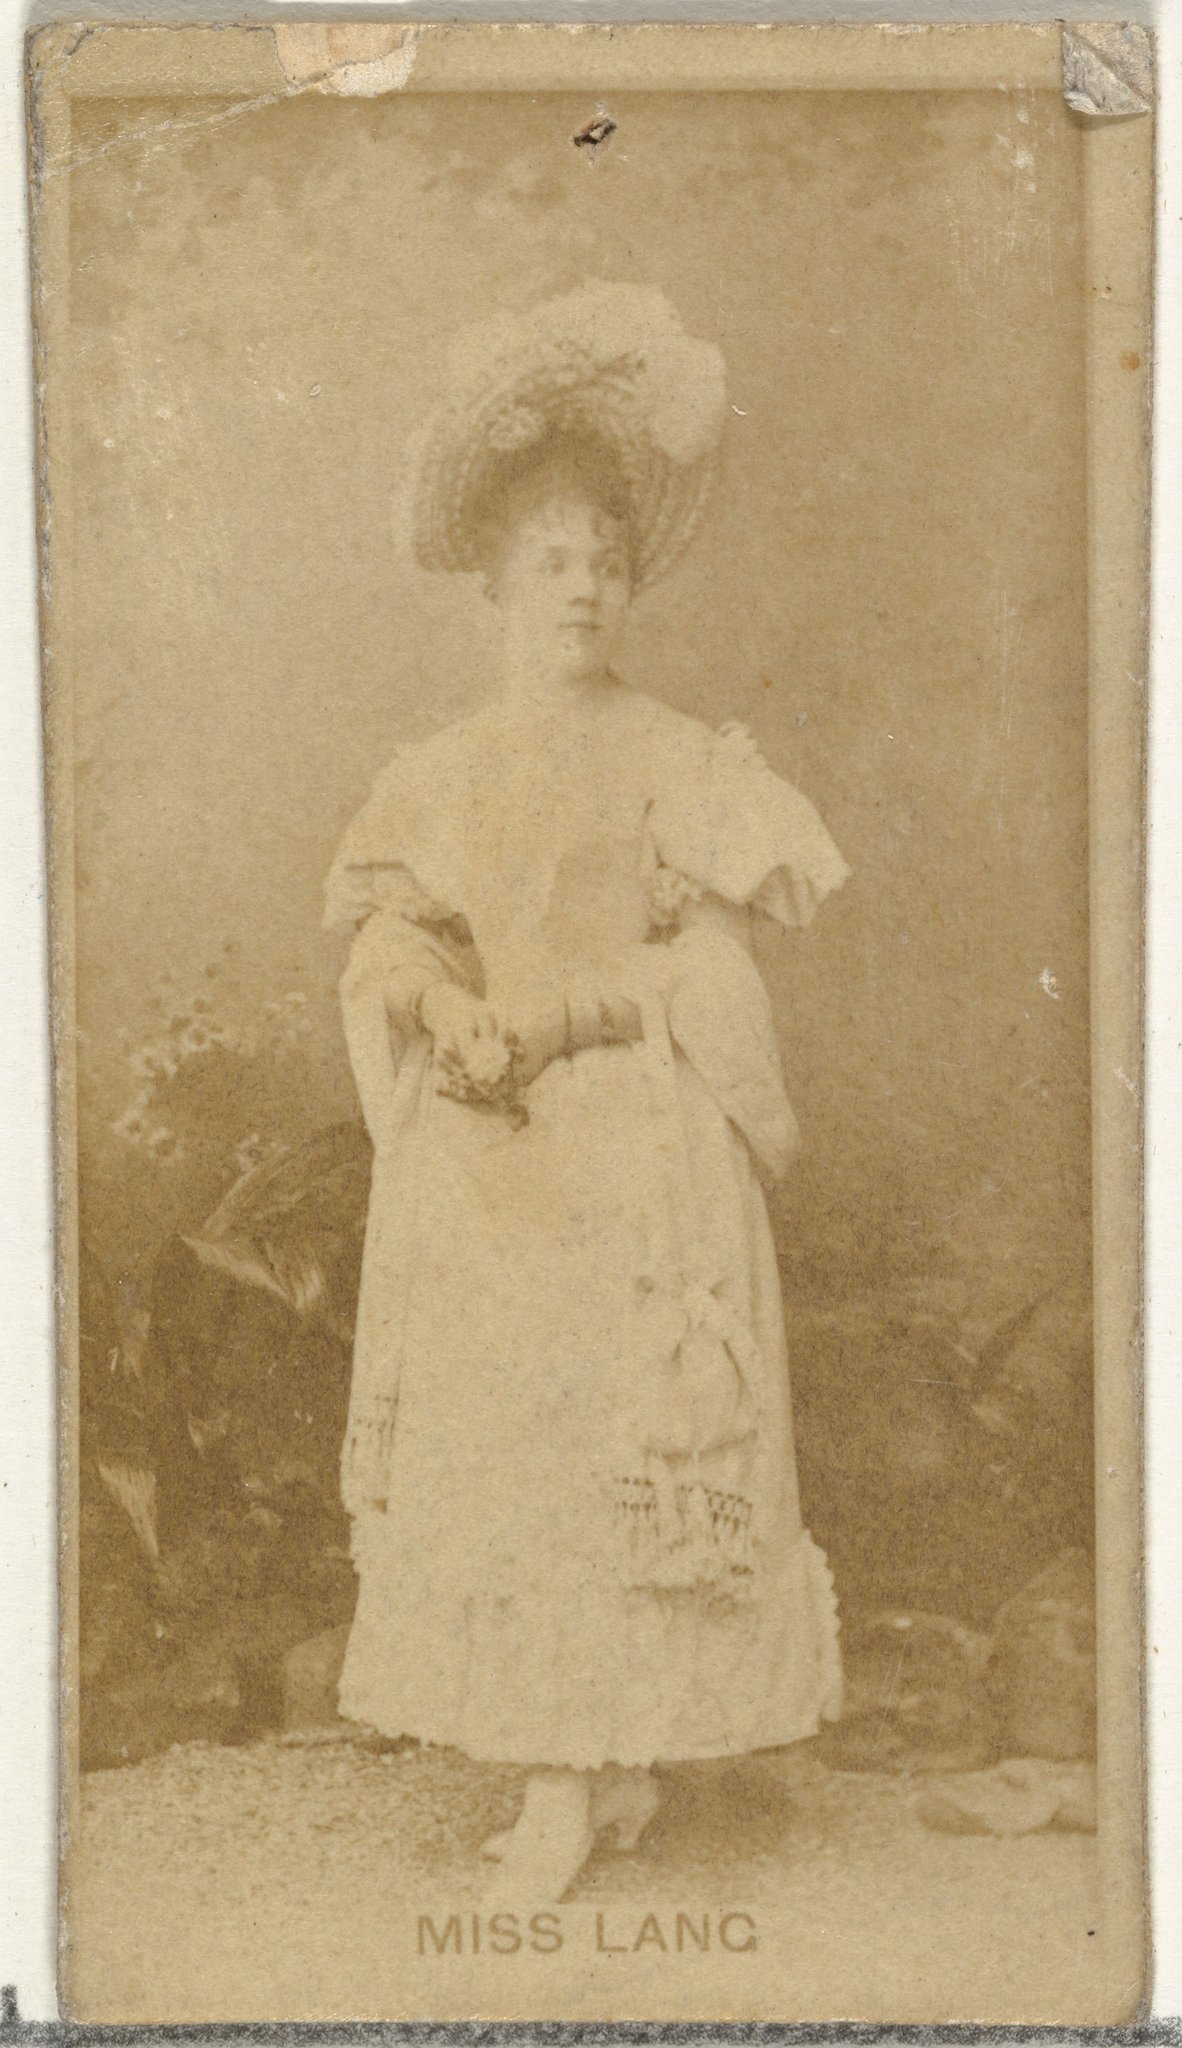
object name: photograph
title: Miss Lang, from the Actors and Actresses series (N145-8) issued by Duke Sons & Co. to promote Duke Cigarettes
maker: w. duke, sons & co.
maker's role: publisher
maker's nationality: american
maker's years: 1870-1920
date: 1891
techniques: albumen silver print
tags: portraits,women,actresses